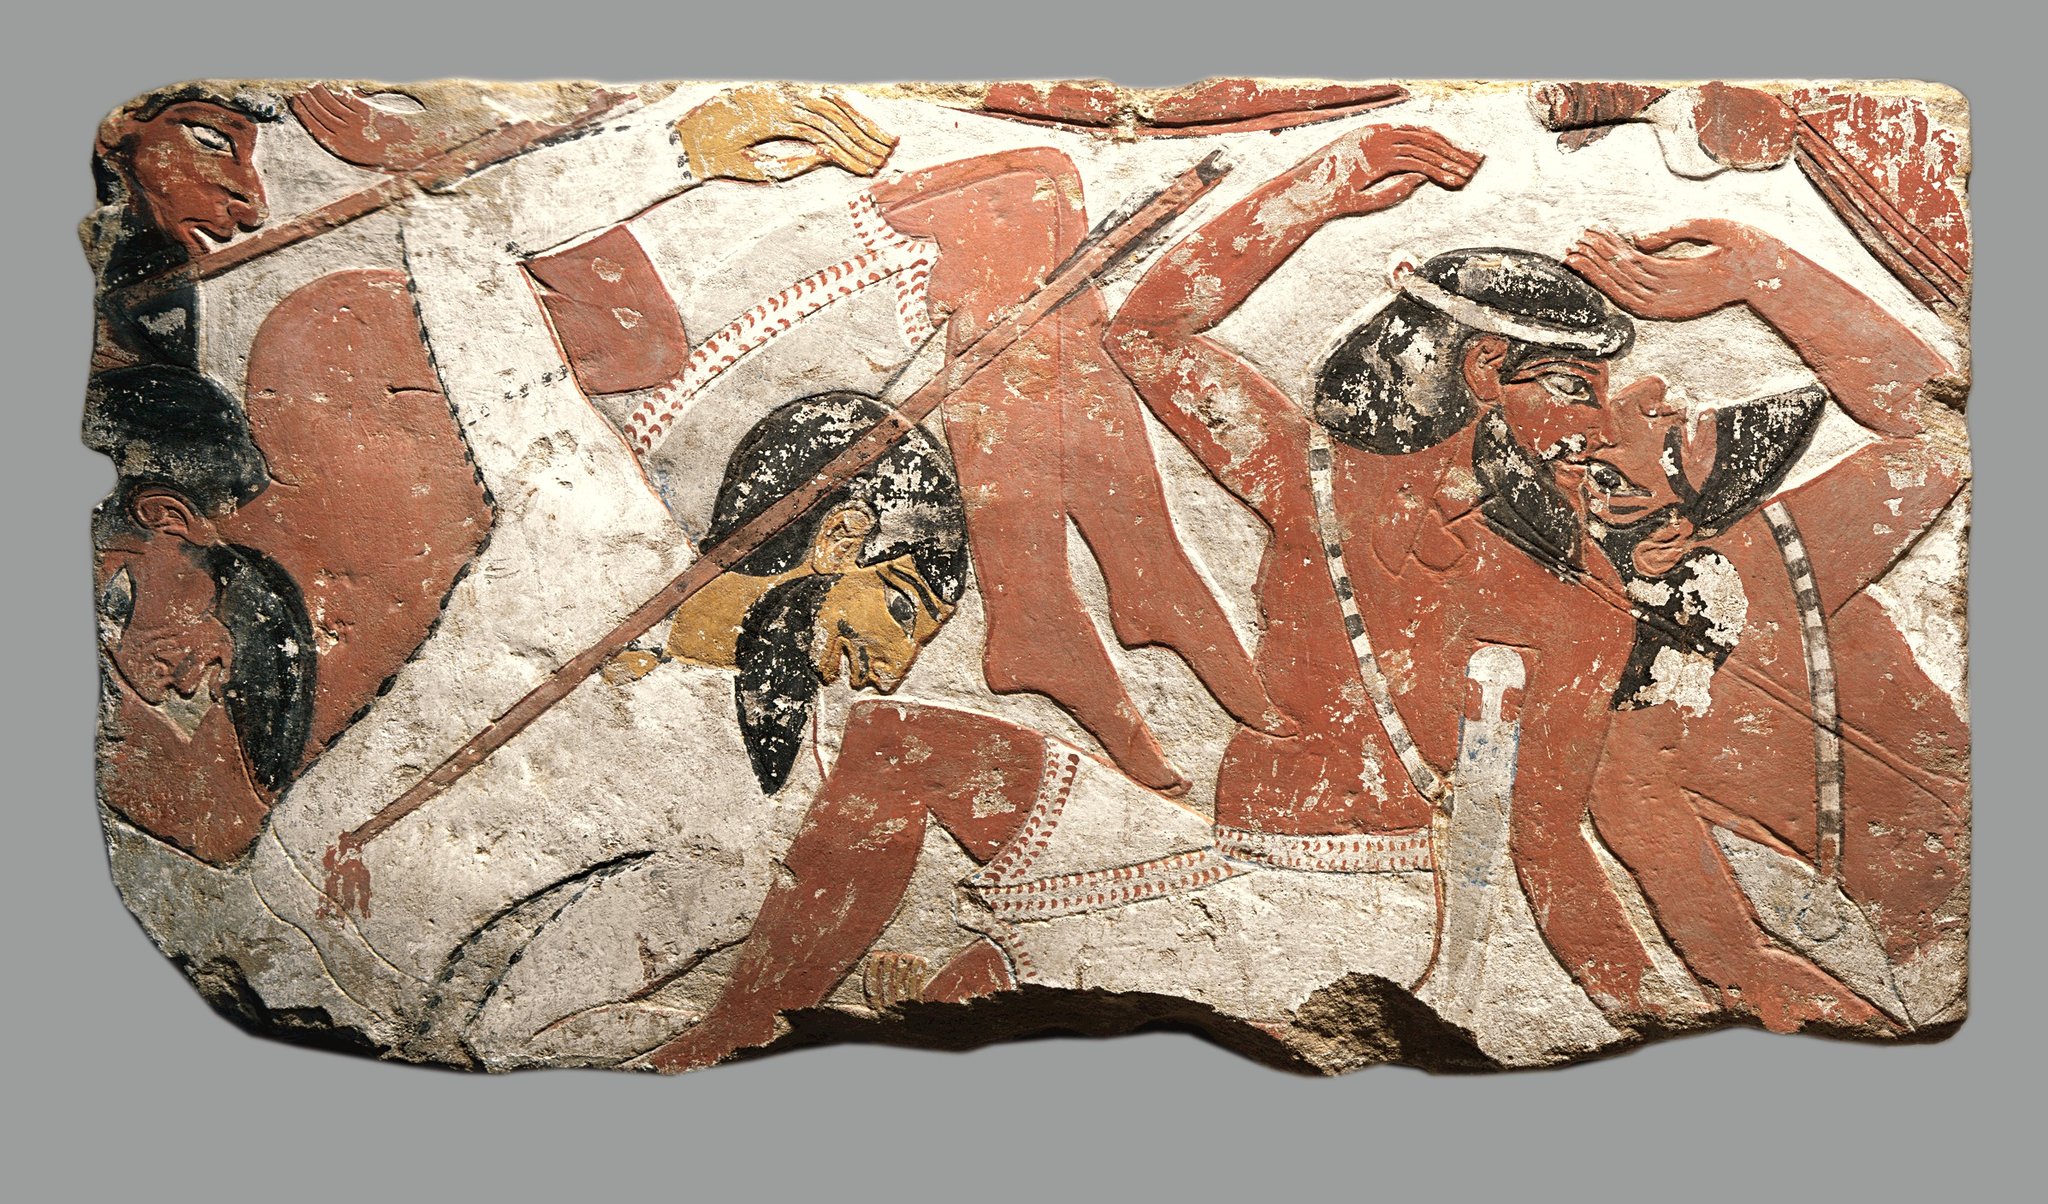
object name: relief, battle scene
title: Block from a Relief Depicting a Battle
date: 1427-1400 BCE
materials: paint, stone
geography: egypt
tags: battles,men